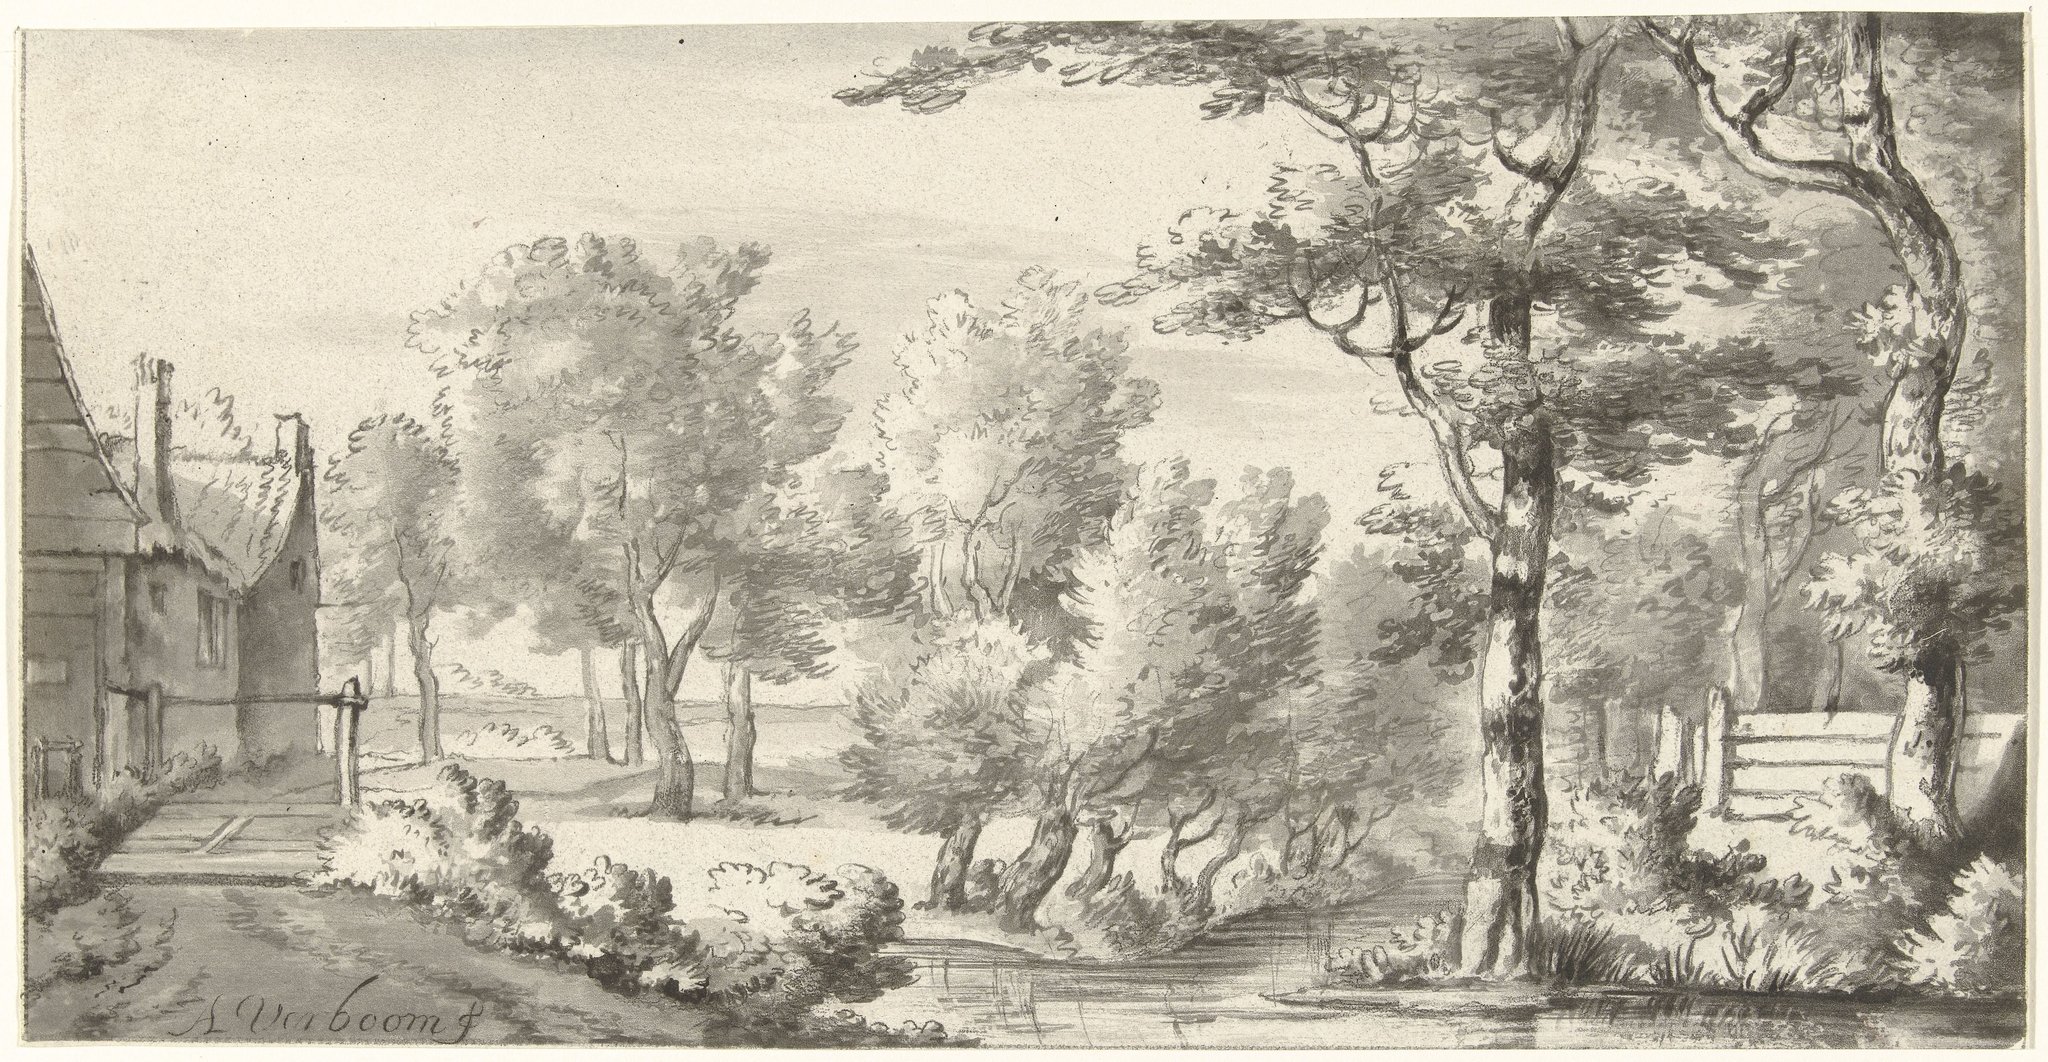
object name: print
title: Landschap met boerderij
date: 1821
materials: paper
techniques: aquatint, etching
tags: farm or solitary house in landscape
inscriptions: collector's mark: Lugt 2725, collector's mark: Lugt 12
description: Door Christiaan Josi opgenomen in een uitgave met 100 werken naar Hollandse en Vlaamse meesters: Collection d'imitations de dessins d'après les principaux maîtres hollandais et flamands, Londen, C.Josi, 1821. Alle prenten in deze uitgave dragen op het verso het wapen van Cornelis Ploos van Amstel, de initiatiefnemer voor de uitgave.